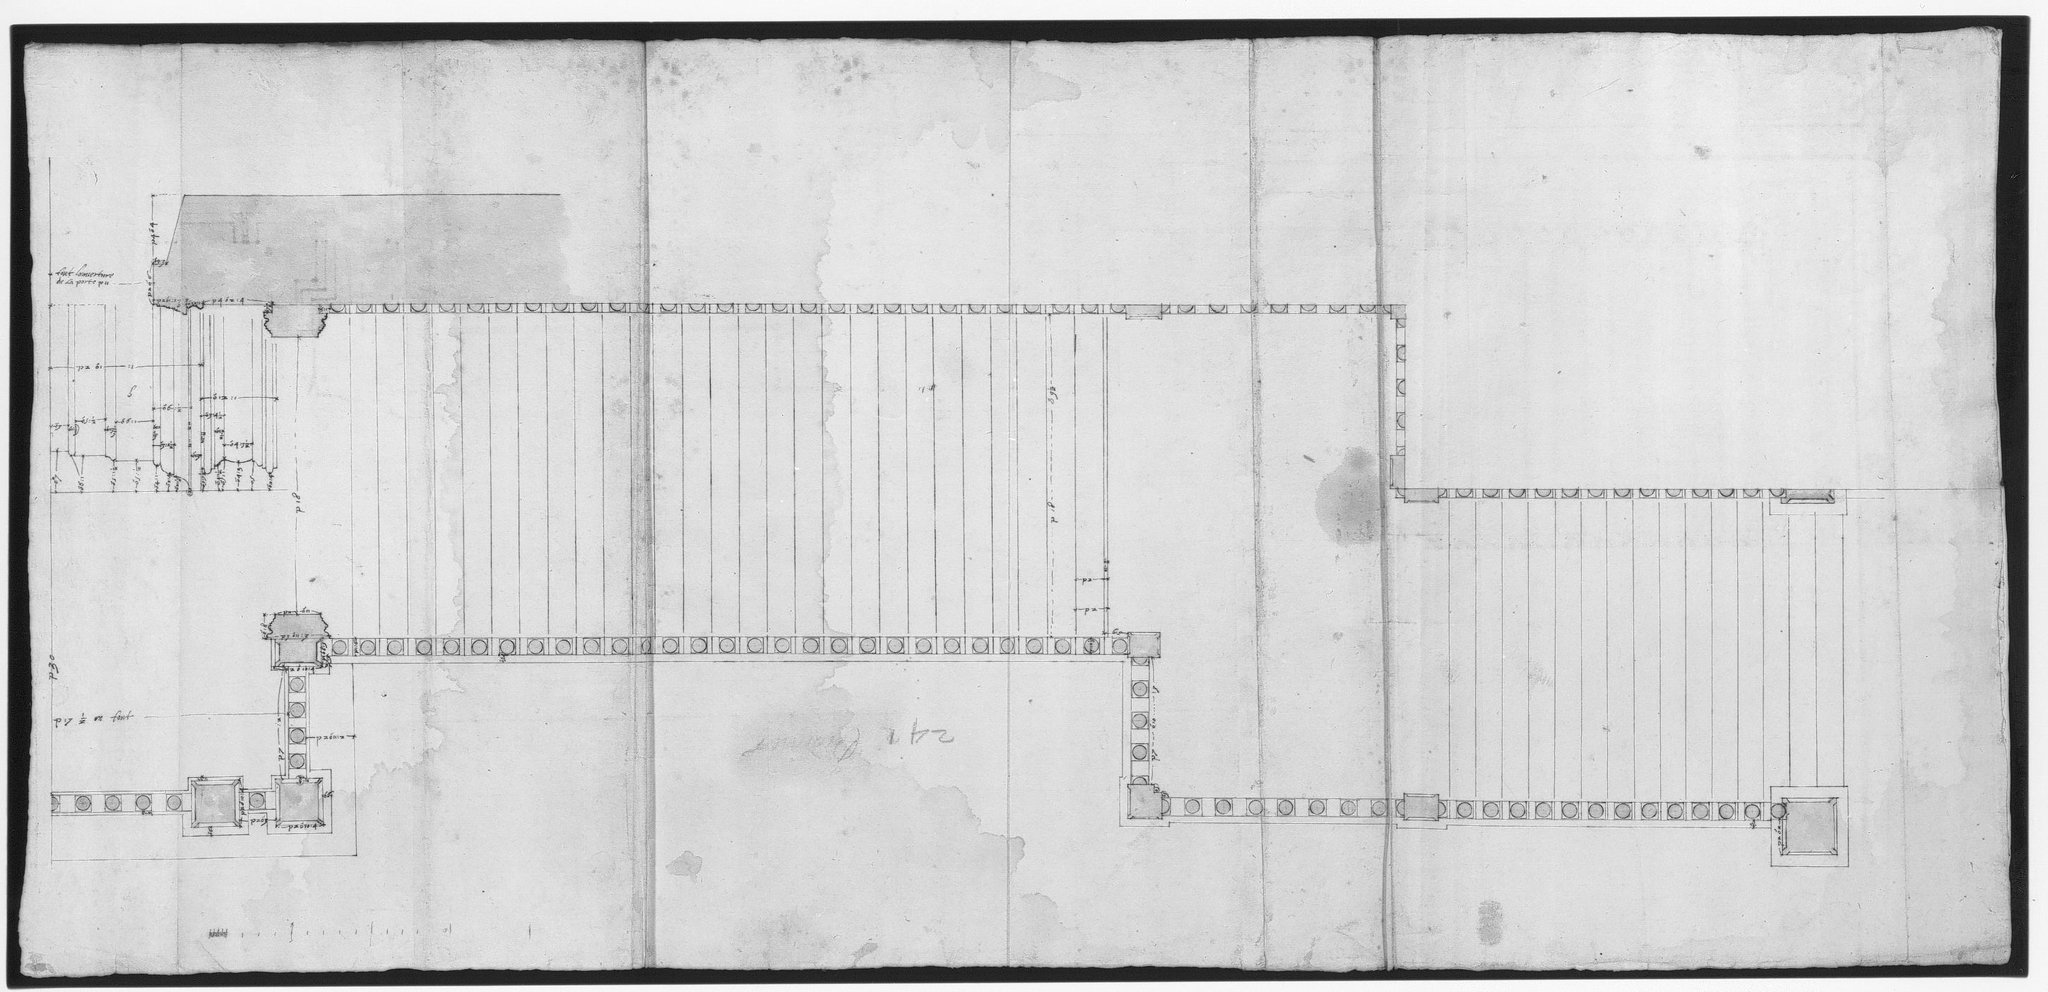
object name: drawing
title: Palazzo Senatorio, stair, upper ramp and entry portal (recto) Palazzo Senatorio, stair, lower ramp and pedestal (verso)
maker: anonymous, french, 16th century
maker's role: draftsman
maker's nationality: french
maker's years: 1500-1600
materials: chalk, ink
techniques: incising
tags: architecture,stairs